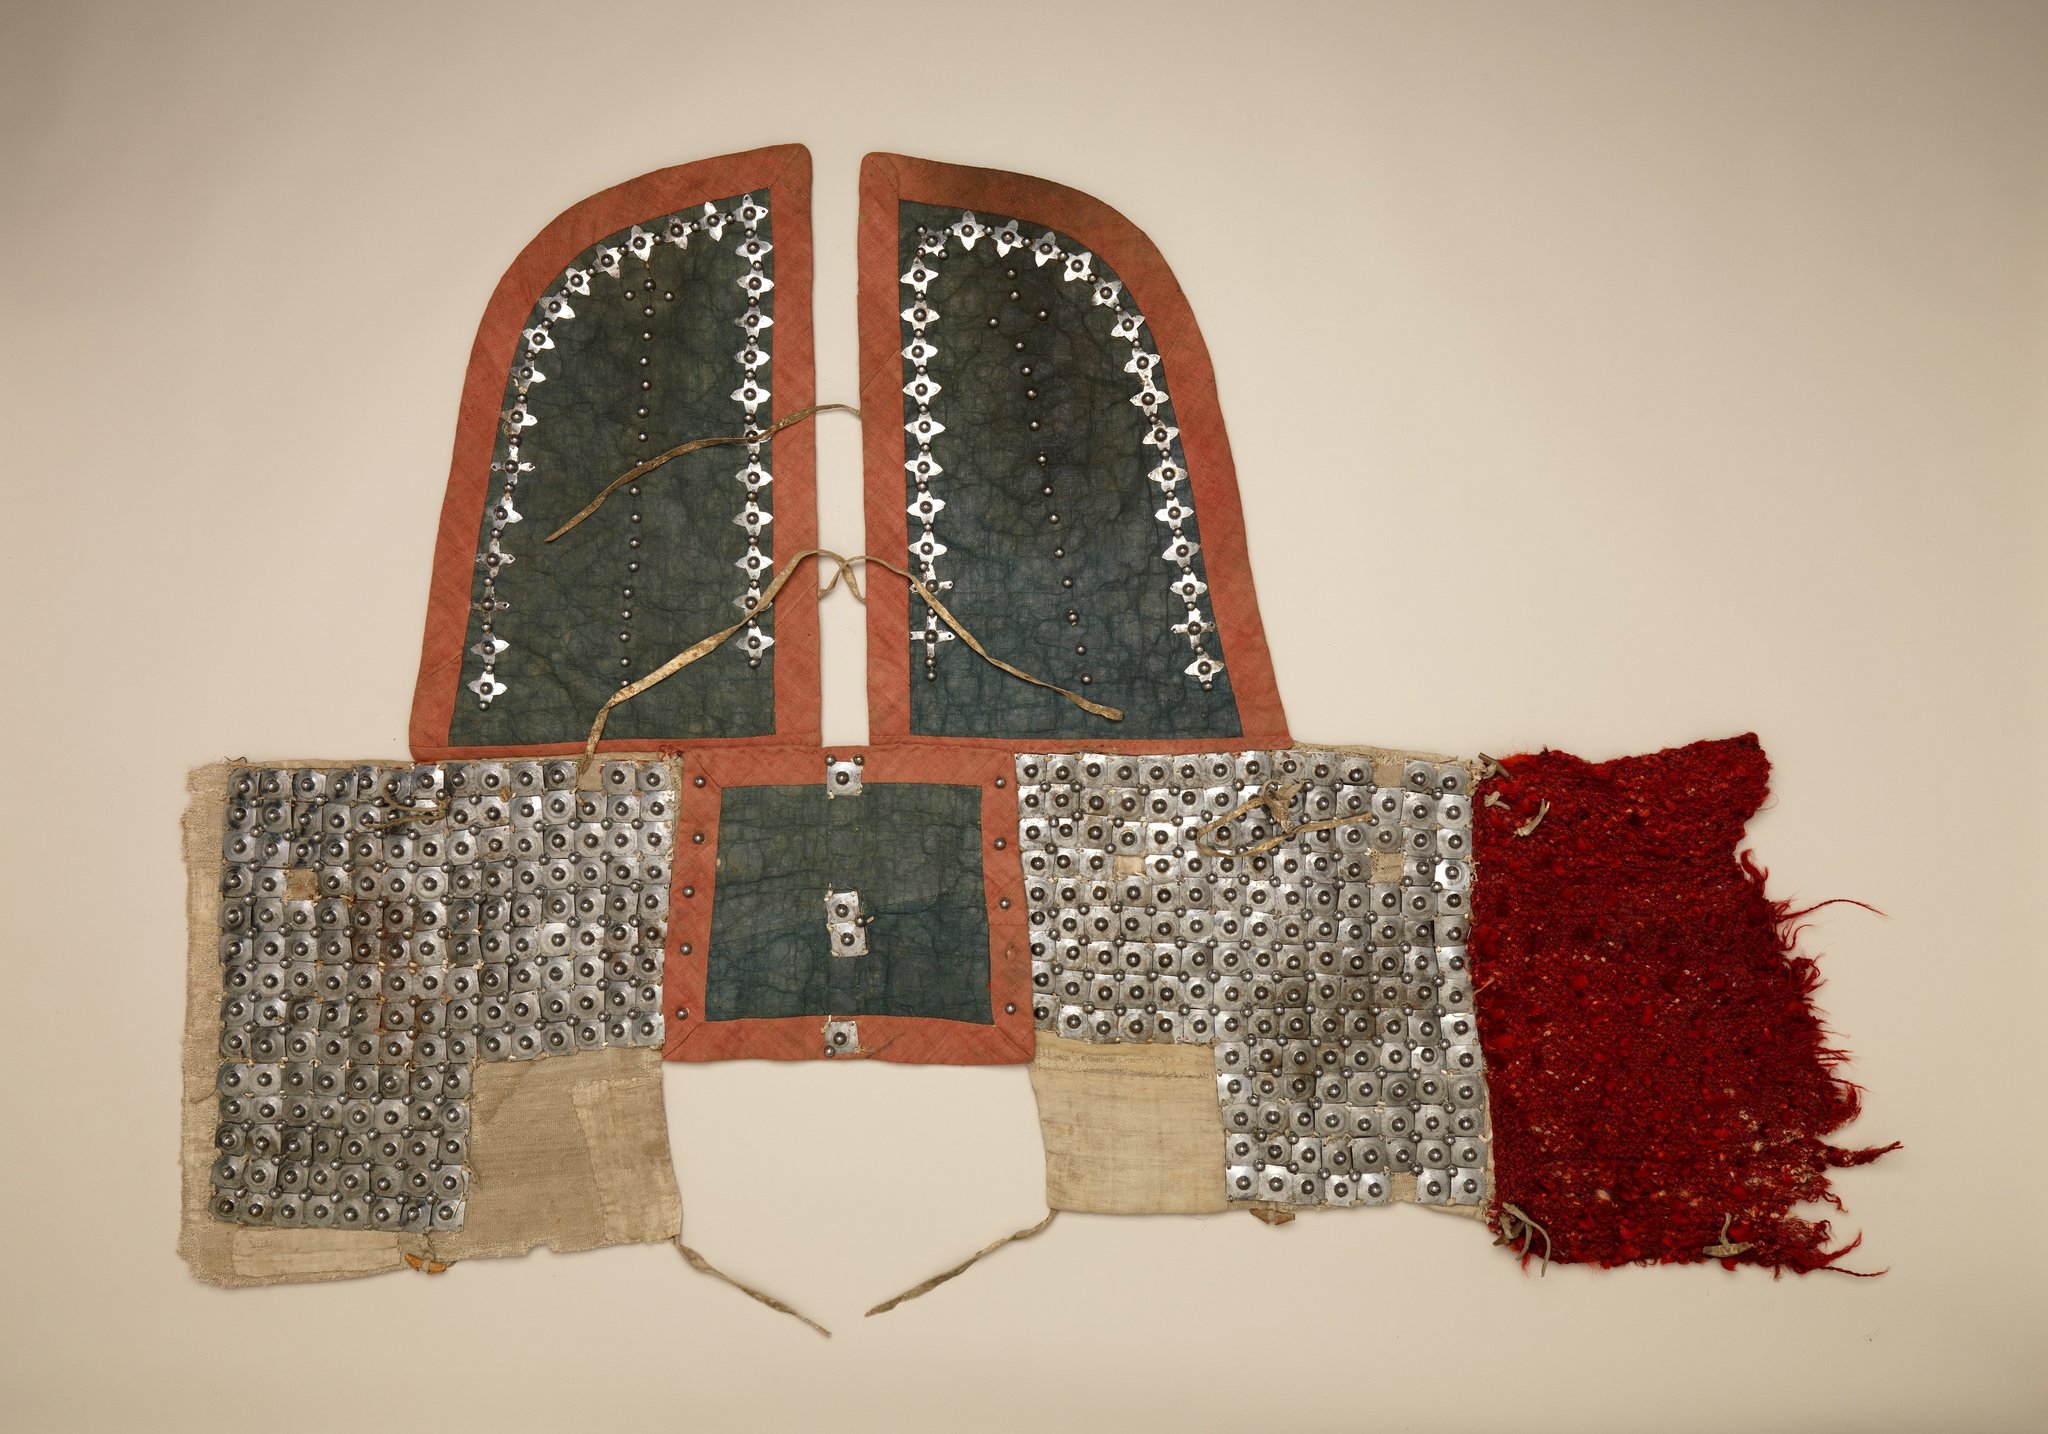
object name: crinet and shoulder defense for a horse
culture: western tibetan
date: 1601-1700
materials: hair, horn, iron, leather, textile, wood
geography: tibet